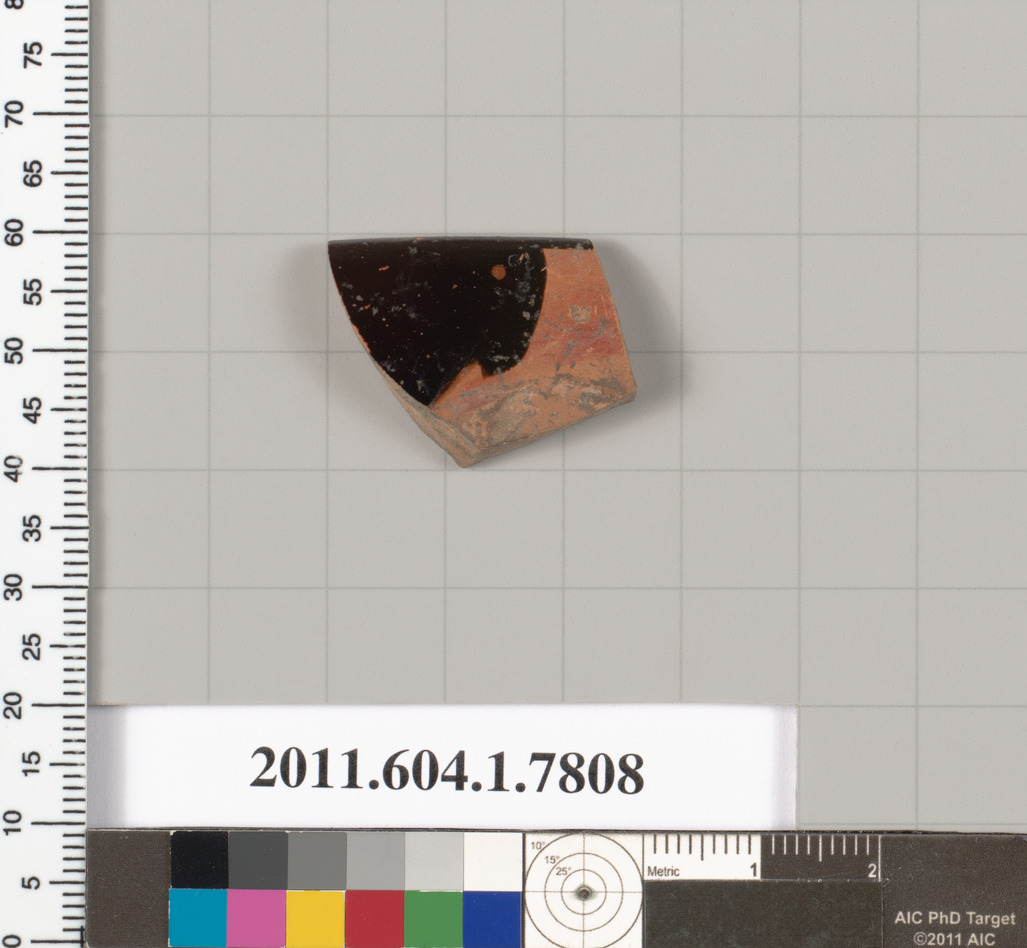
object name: kylix fragment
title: Terracotta rim fragment of a kylix (drinking cup)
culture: greek, attic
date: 460-450 BCE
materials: terracotta